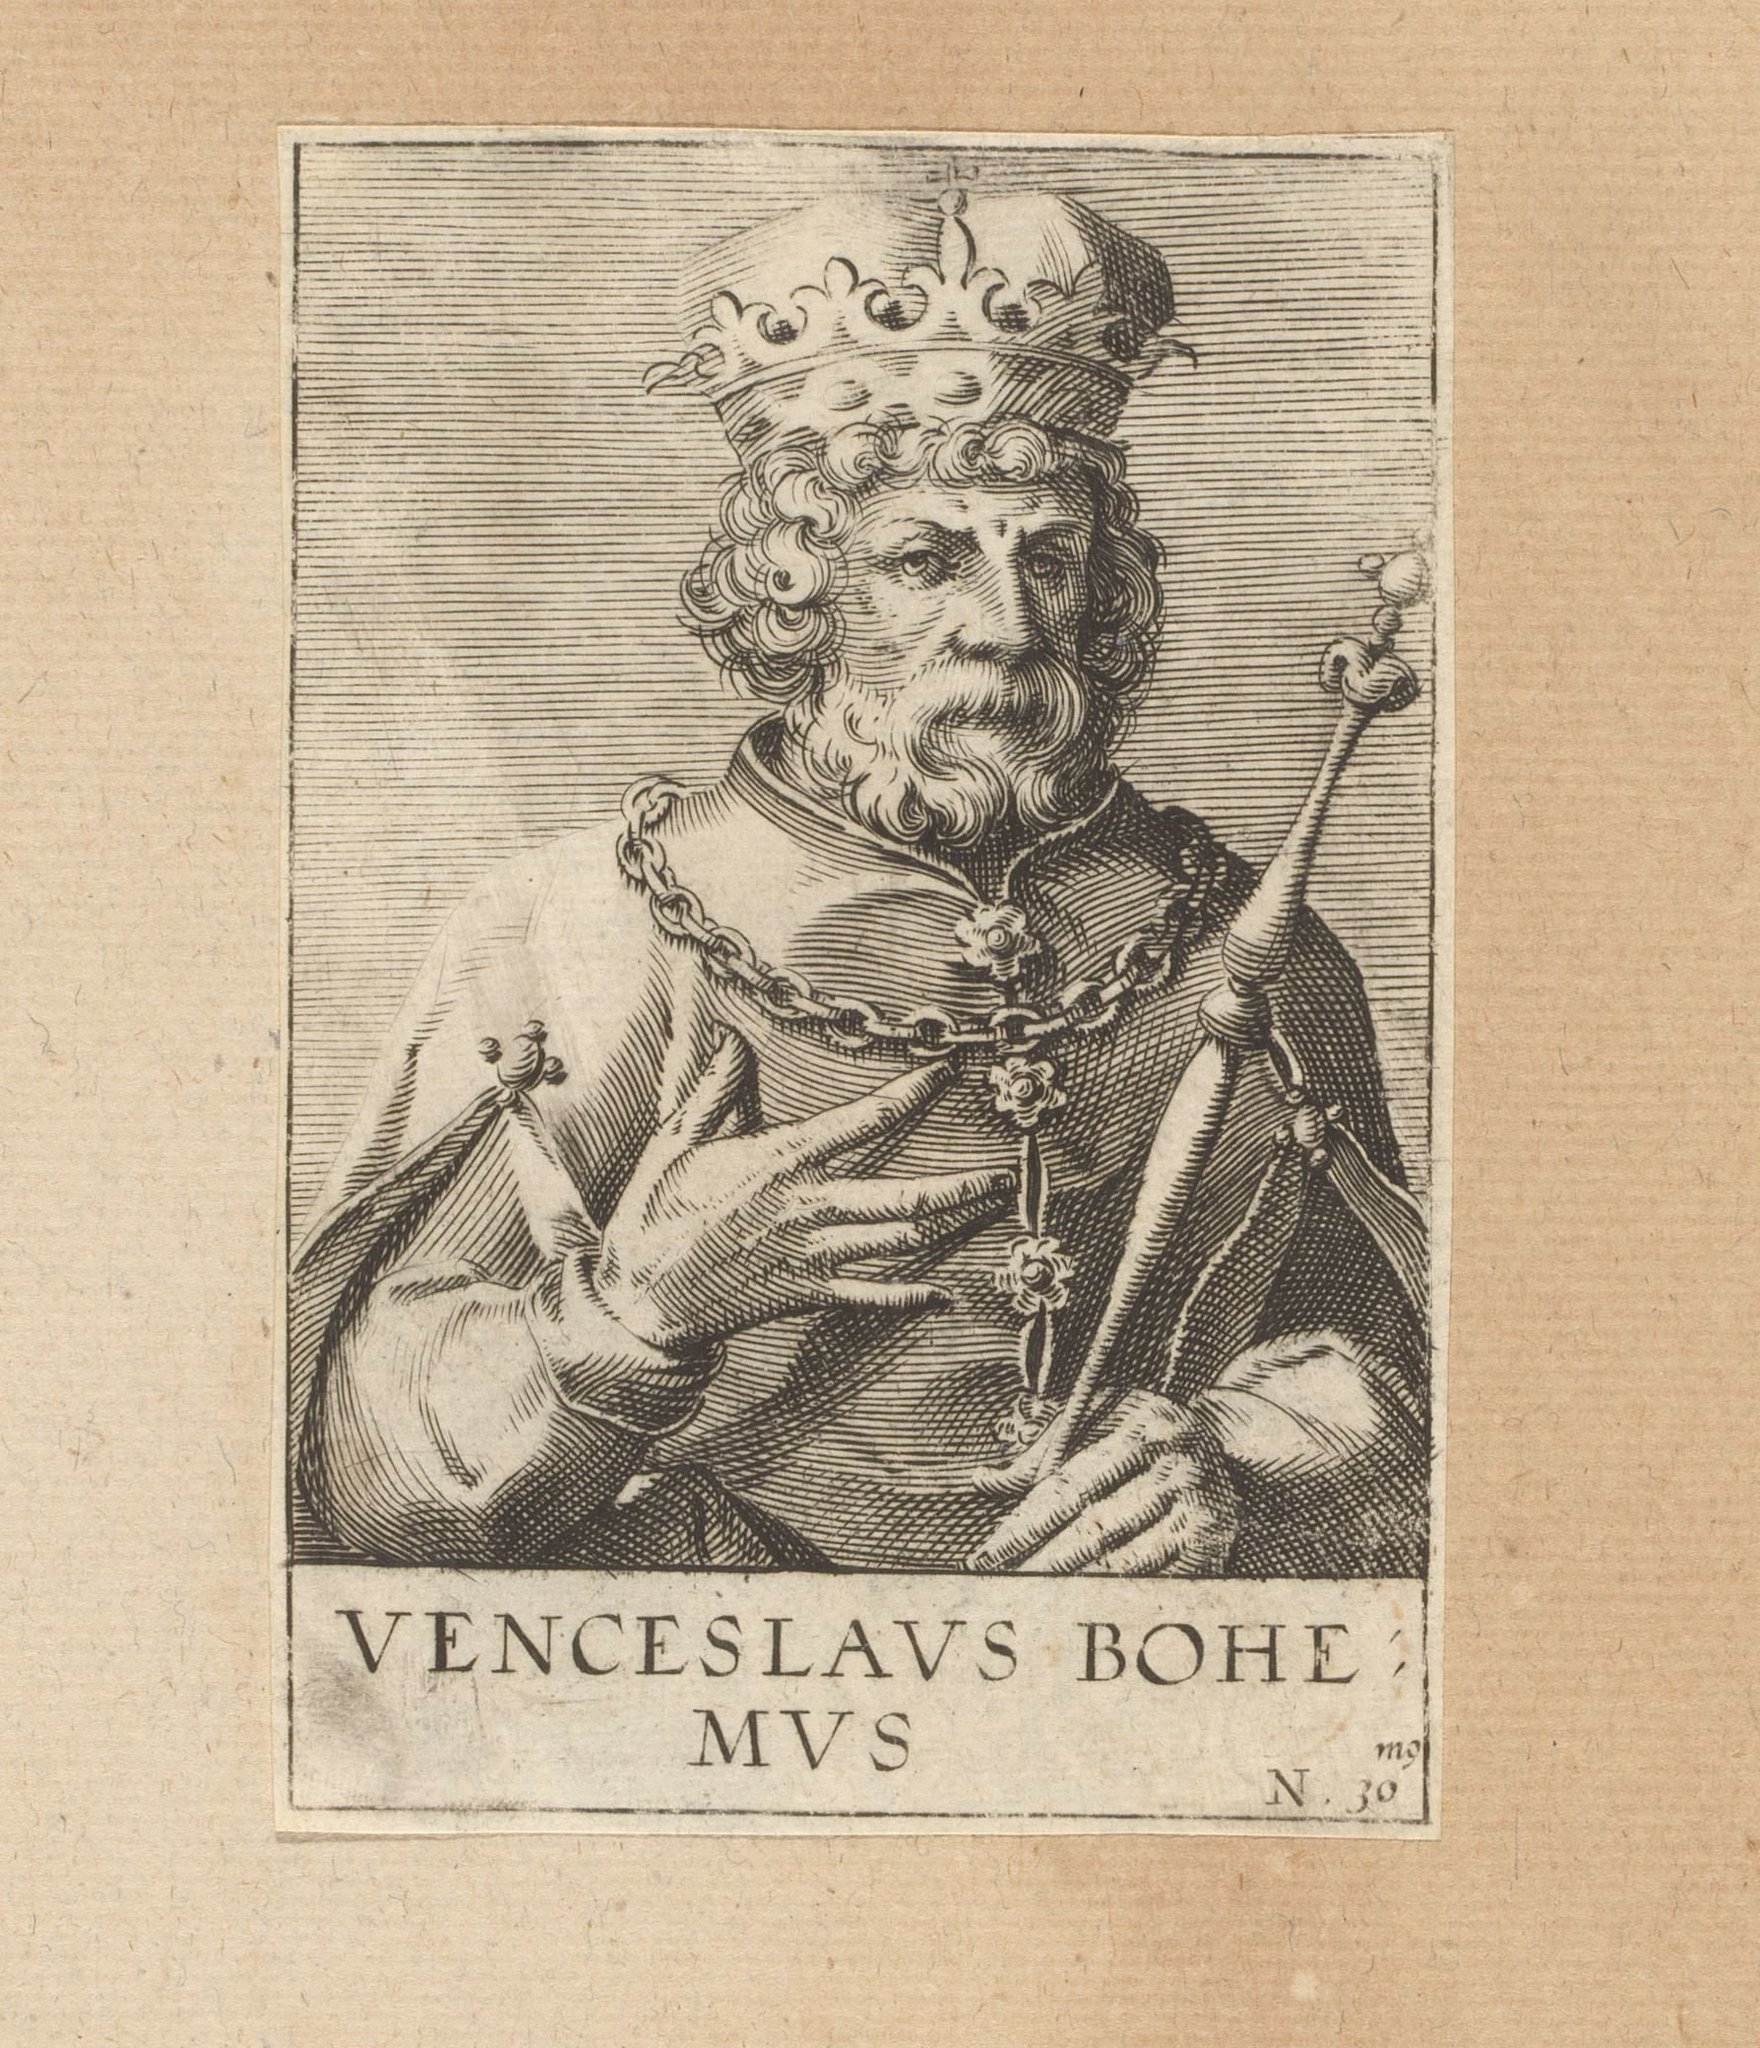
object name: album leaf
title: Portret van Wenceslaus II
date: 1574-1594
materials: paper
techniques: woodcut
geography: cologne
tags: prague, historical persons, king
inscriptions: collector's mark: Lugt 240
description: Prent gebruikt in: Mylius, Arnold. Principum et Regum Polonorum Imagines ad Vivum Expressae (...). Keulen: Gottfried von Kempen, 1594.